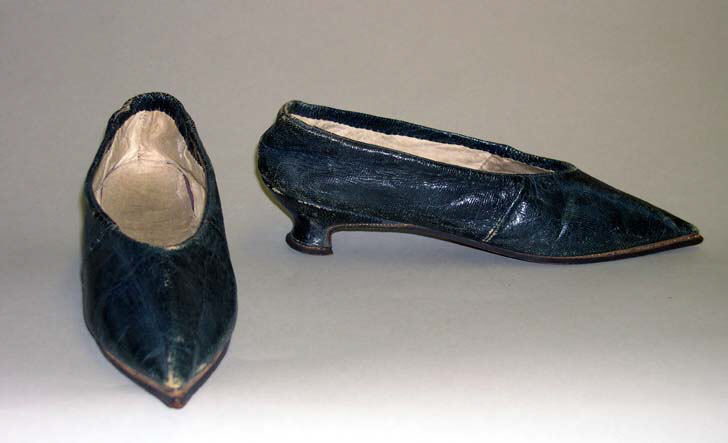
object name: slipper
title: Slippers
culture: british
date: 1790-1799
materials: leather